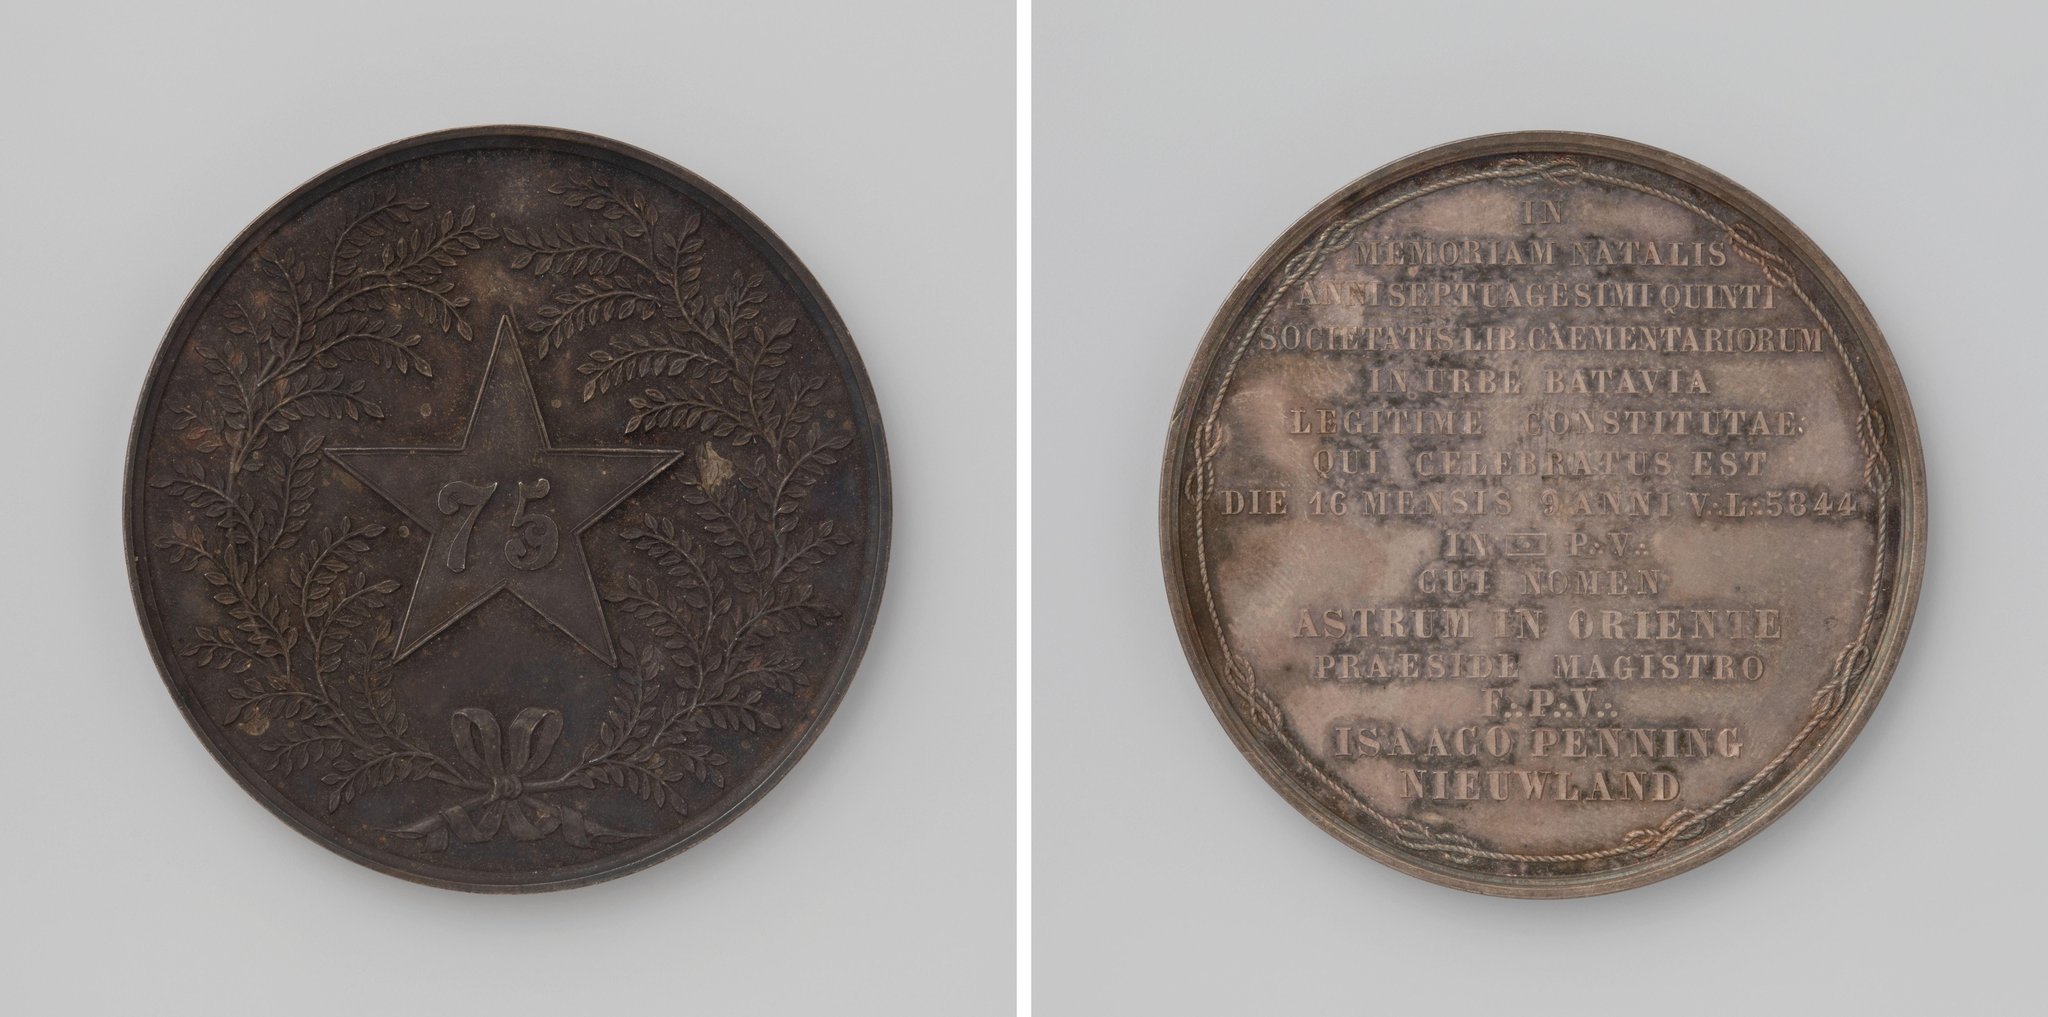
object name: history medal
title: Vijfenzeventigjarig herdenking van de invoering van de vrijmetselarij te Batavia, gevierd door de loge "De ster in het Oosten"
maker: jacob wiener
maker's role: medailleur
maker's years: 1815-1899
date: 1844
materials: silver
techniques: striking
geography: brussels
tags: batavia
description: Zilveren penning. Voorzijde: vijfpuntige ster met opschrift 75 binnen krans van acaciatakken. Keerzijde: opschrift binnen touw met negen knopen